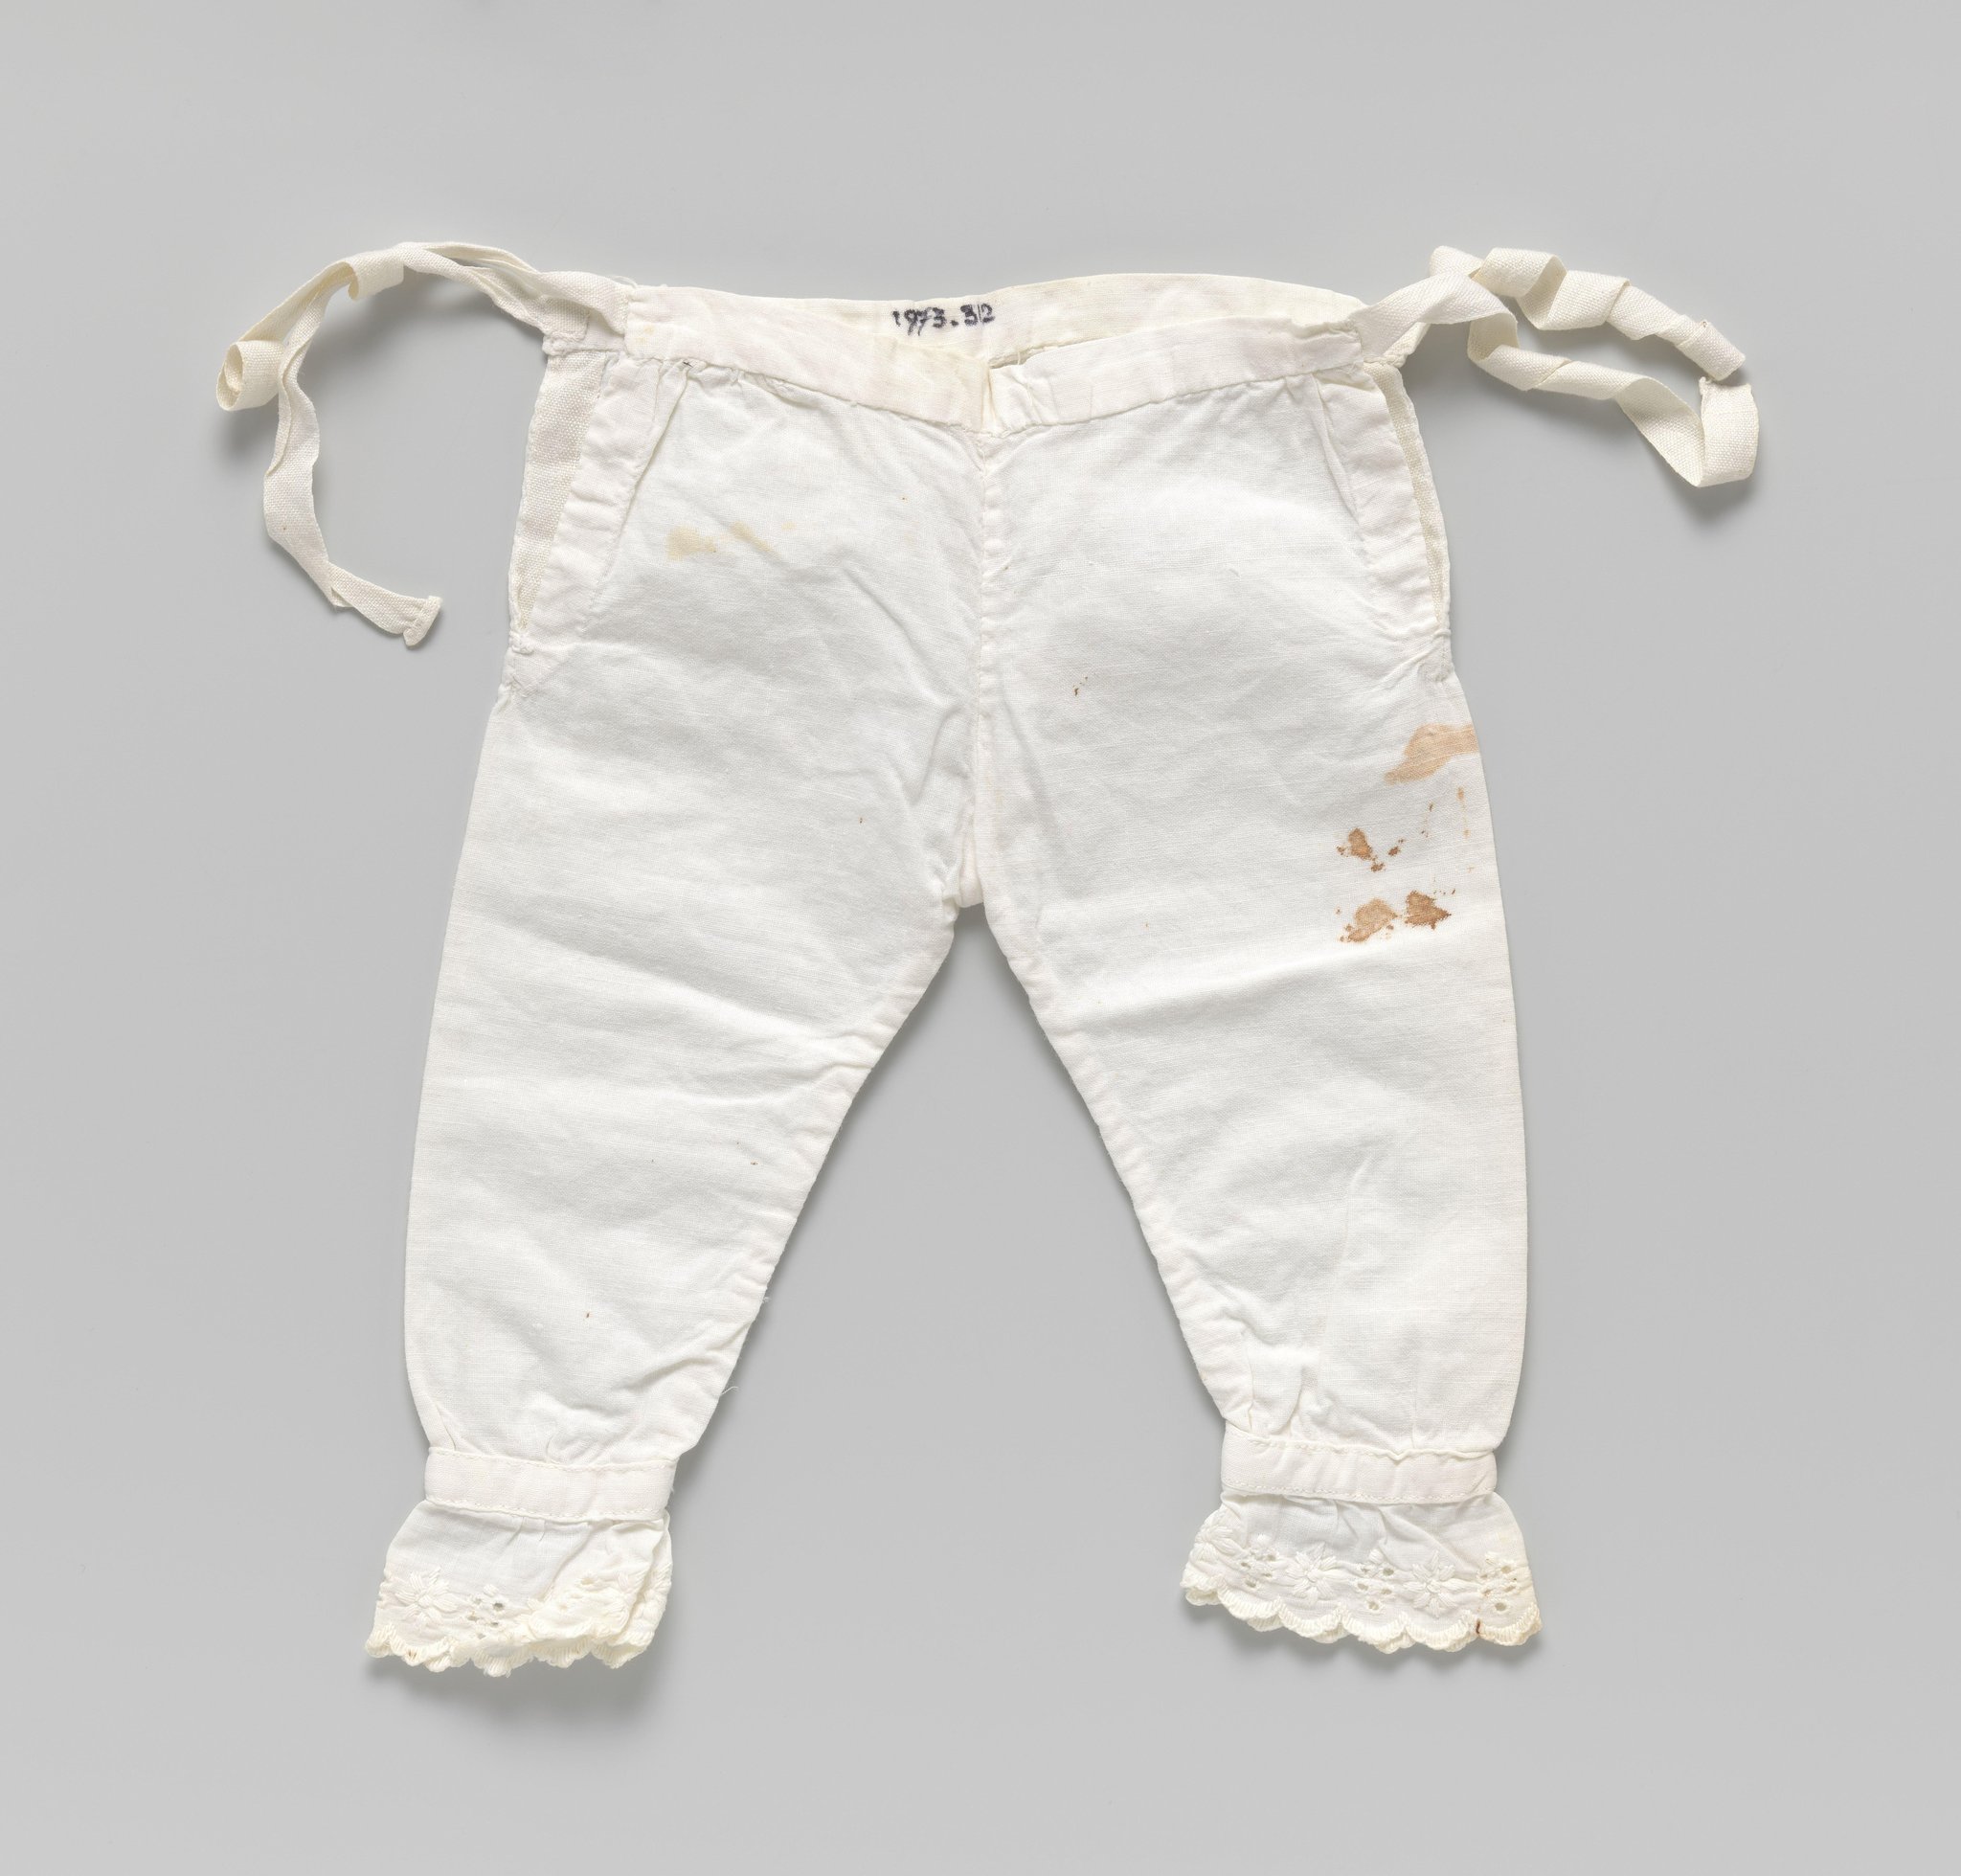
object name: doll's clothing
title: Broek van katoen, met lange pijpen en met banden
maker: p. titjen-baas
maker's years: 1900-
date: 1910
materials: cotton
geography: netherlands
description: Broek van katoen, met lange pijpen en met banden. Behorend bij pop "LILLY".